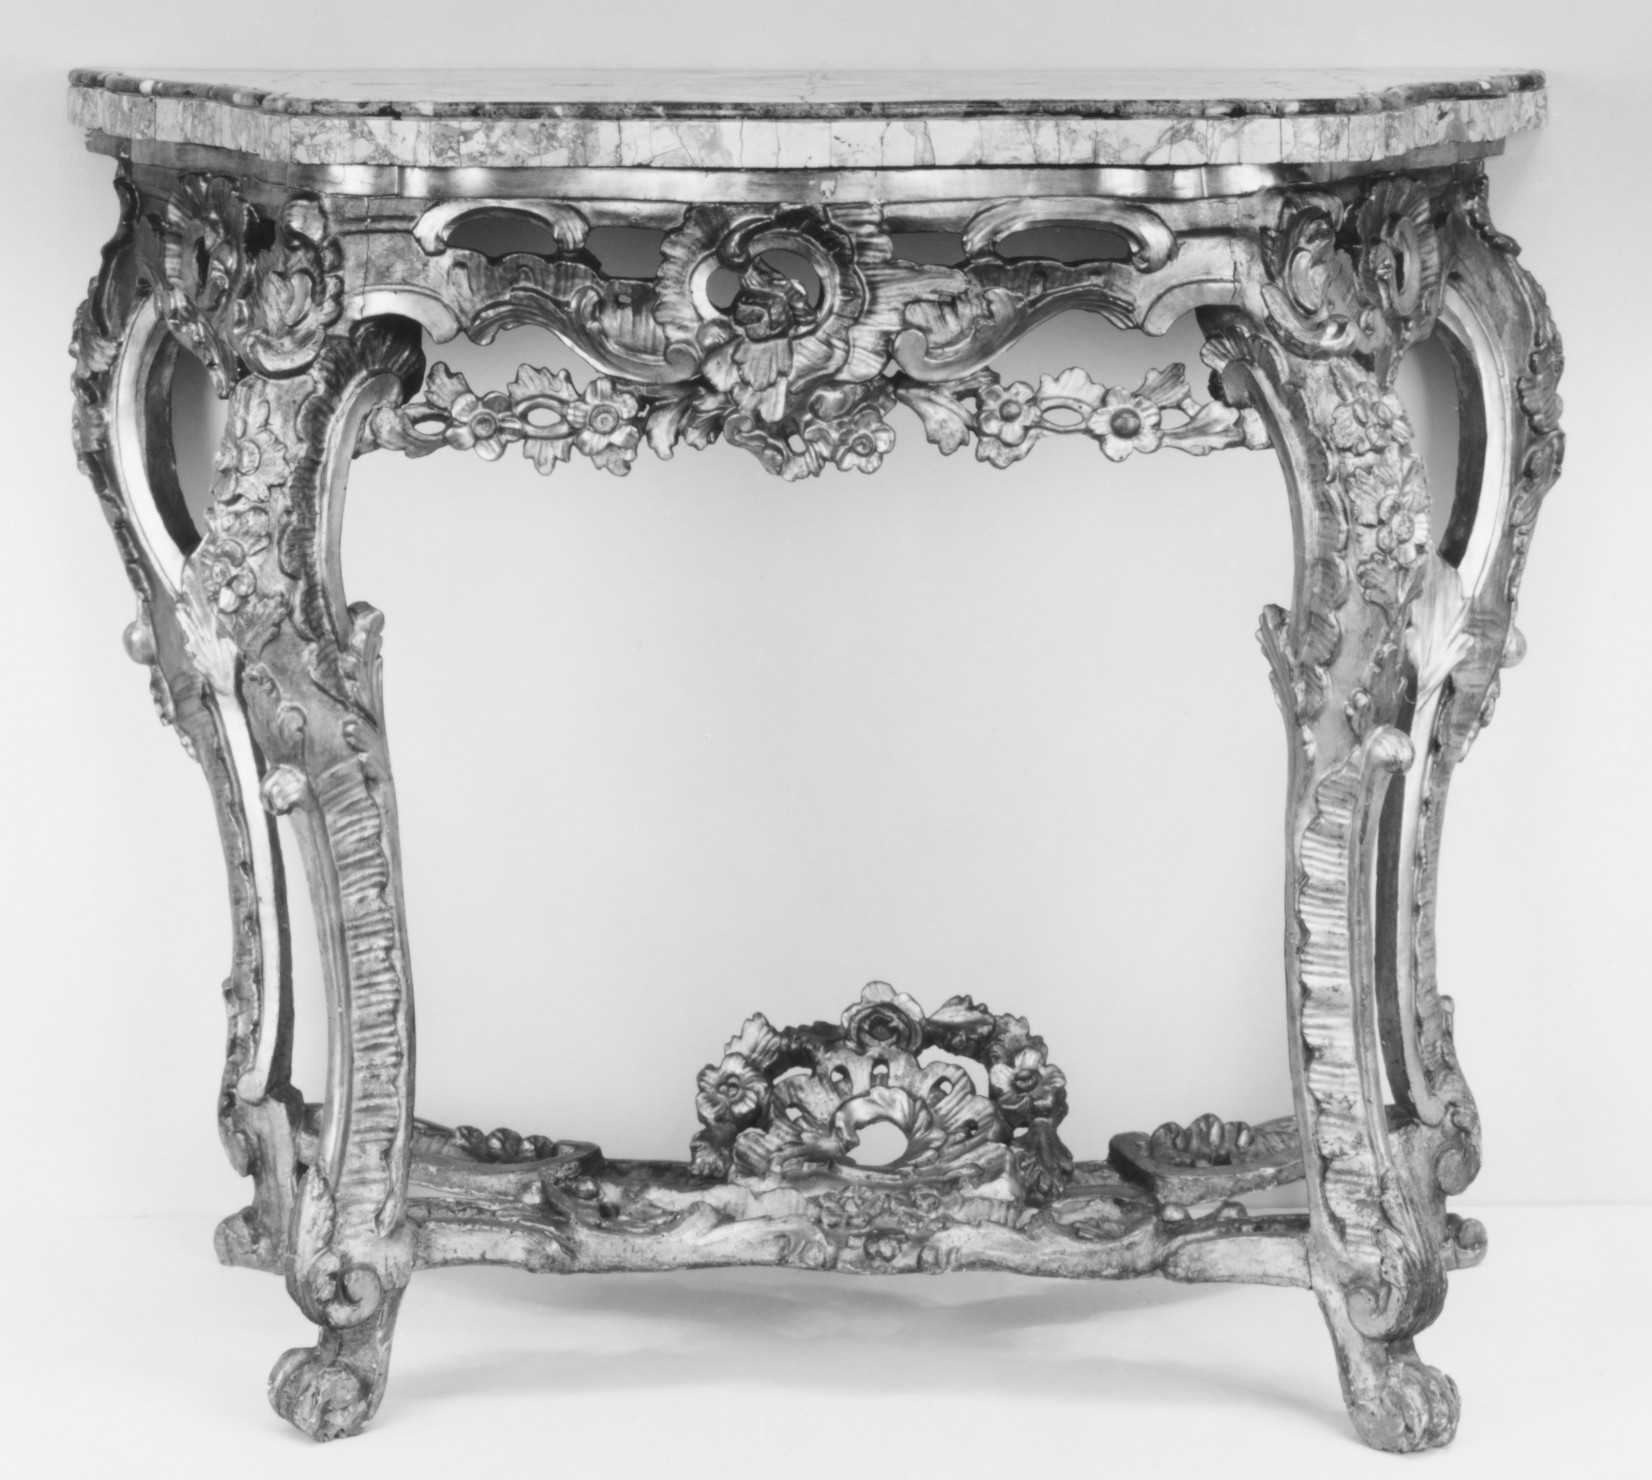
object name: console table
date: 1740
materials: marble, wood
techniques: carving, gilding